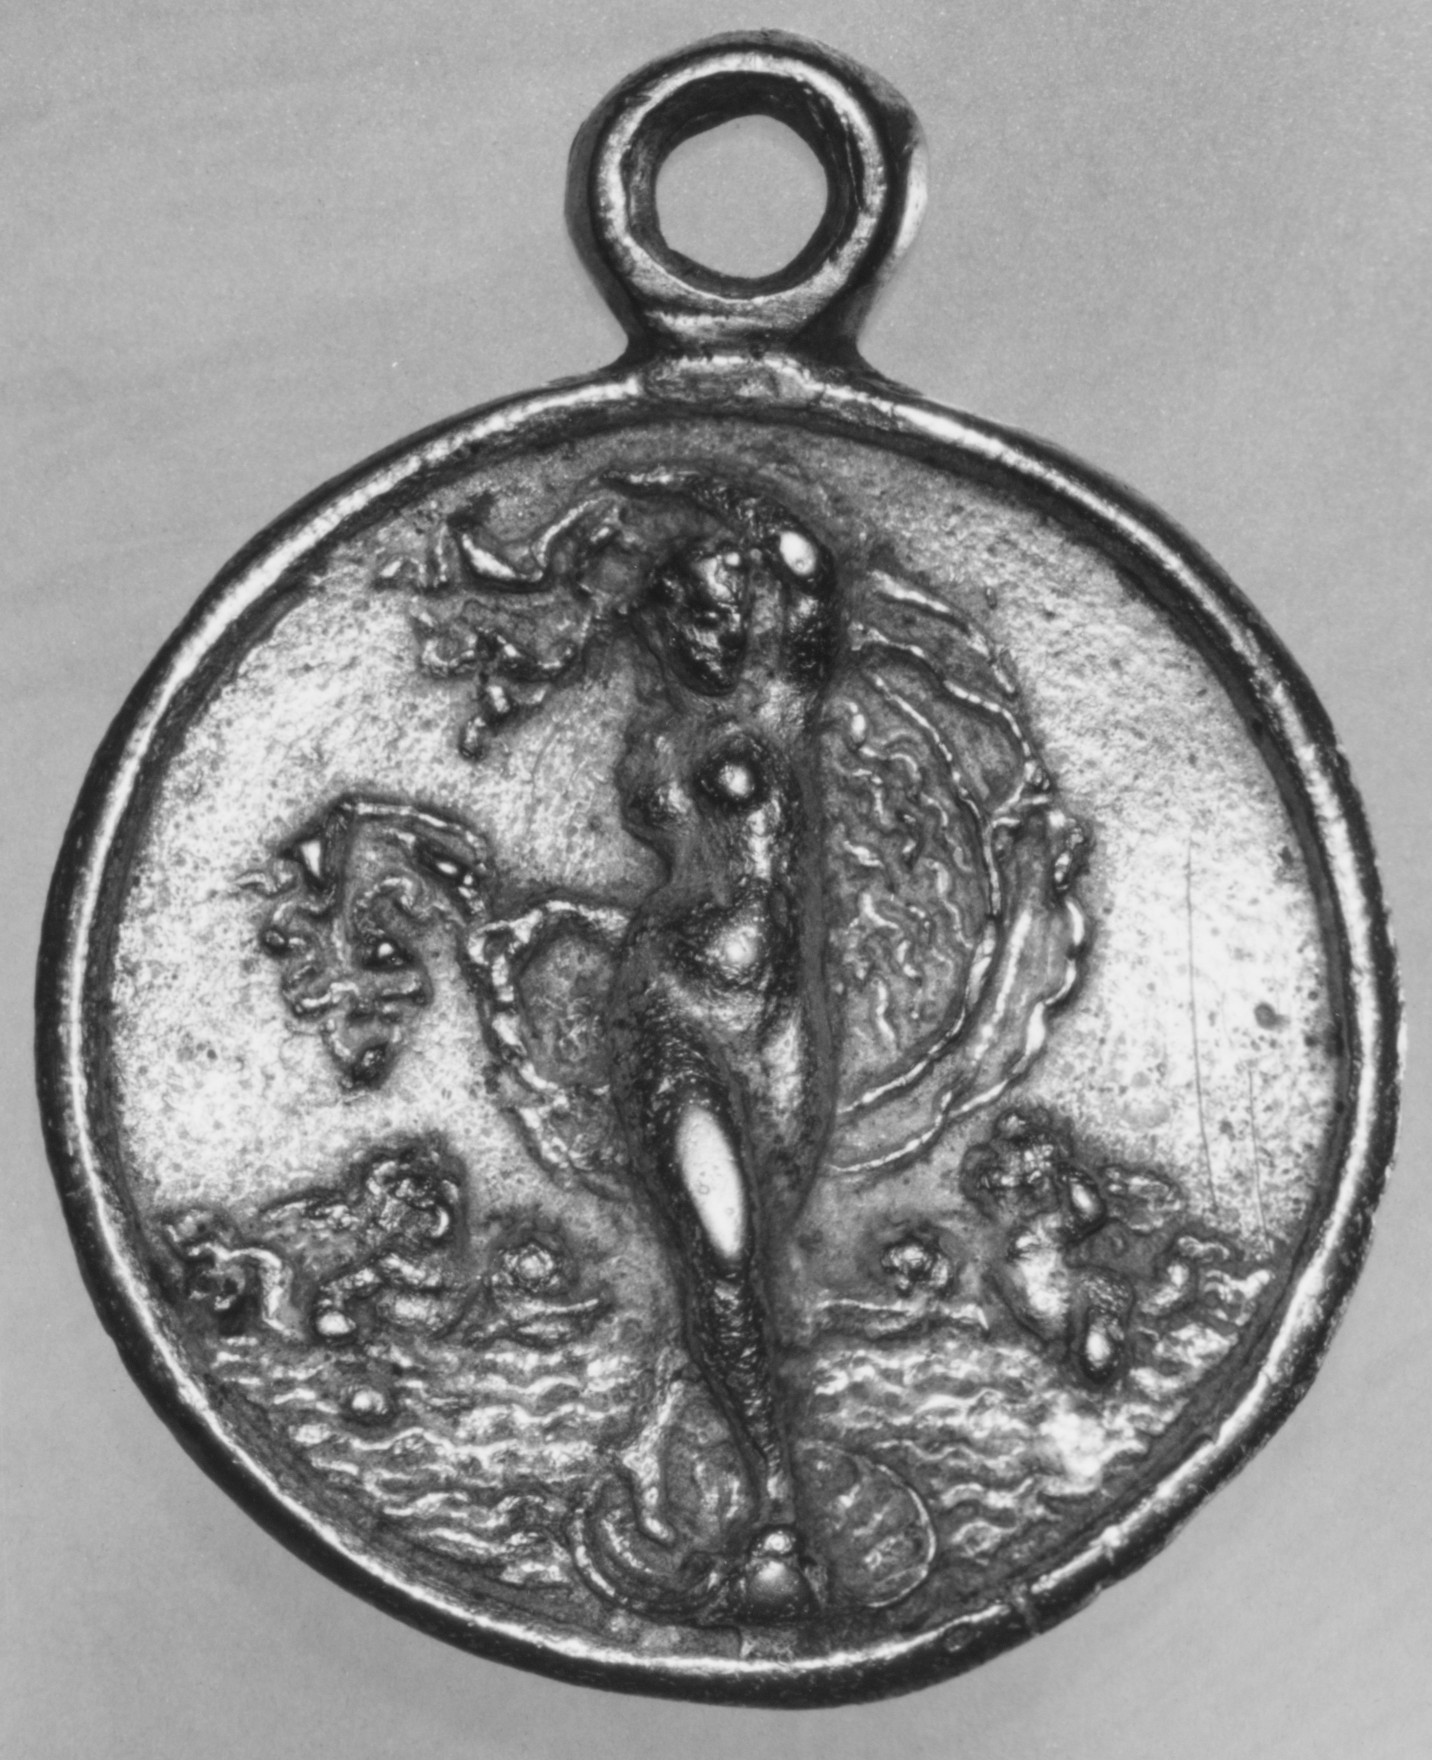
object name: plaquette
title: Birth of Venus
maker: master of the birth of venus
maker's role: artist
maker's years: 1800-1900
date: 1801-1900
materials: gilt bronze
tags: venus,birth